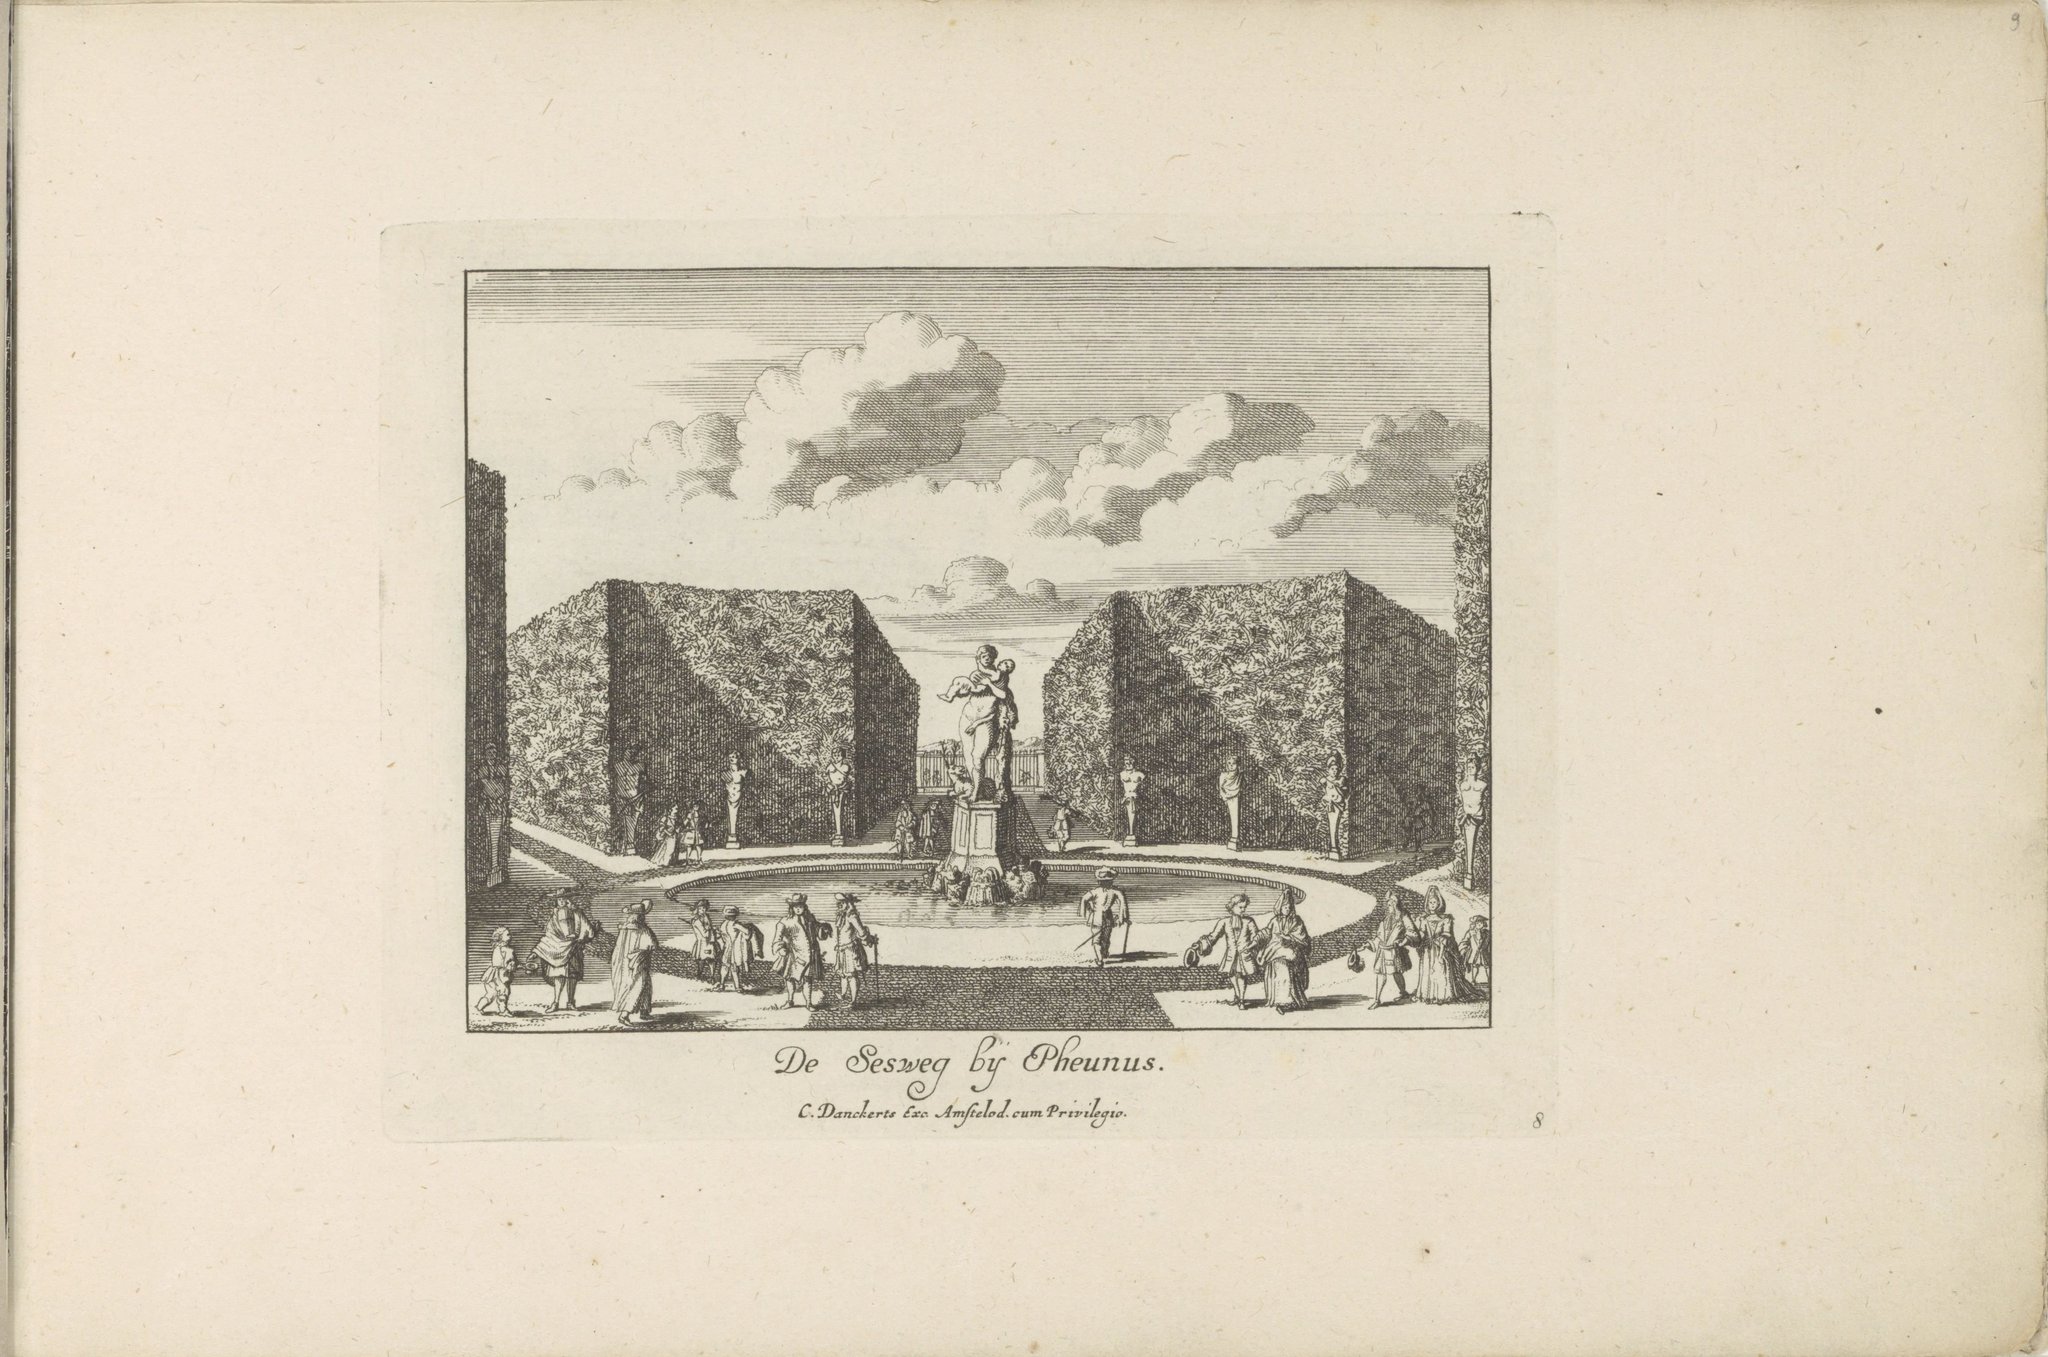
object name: print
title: De Sesweg bij Pheunus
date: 1696-1718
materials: paper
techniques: etching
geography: amsterdam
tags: satyrs, fauns, sileni, french or architectonic garden; formal garden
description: Gezicht op het beeld van Faunus waar zes wegen op uit komen in de tuinen van Paleis Het Loo. Prent maakt deel uit van een album.